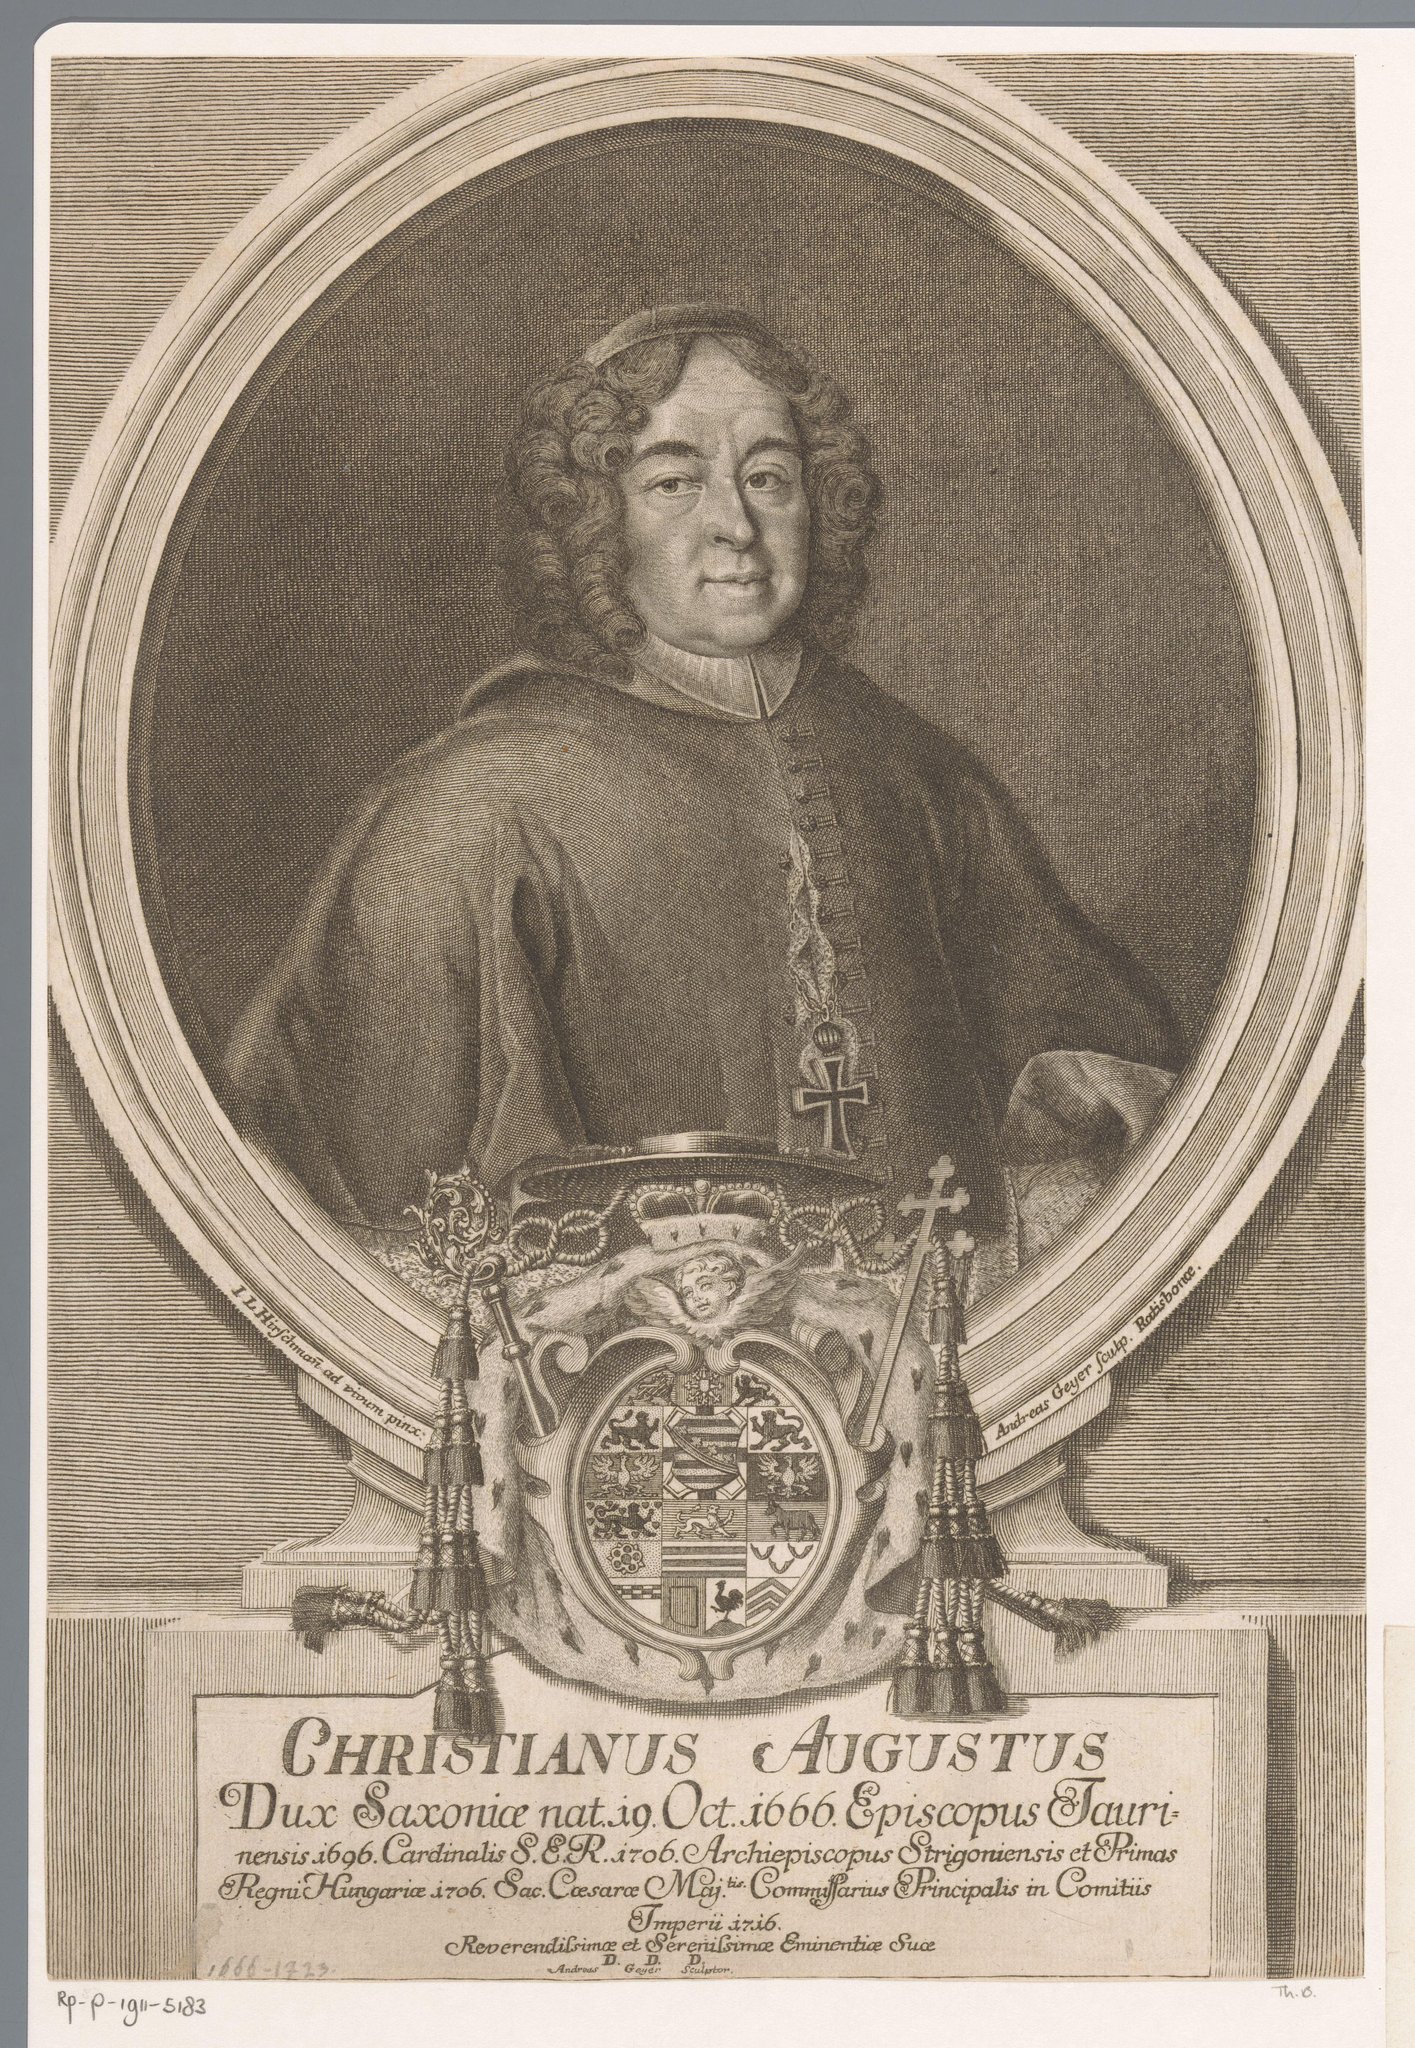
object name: print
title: Portret van Christian August zu Sachsen-Zeitz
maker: andreas geyer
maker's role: print maker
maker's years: -1729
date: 1716-1729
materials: paper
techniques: engraving, etching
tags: archbishop, bishop, etc. (roman catholic), insignia of bishop, e.g. mitre, crozier, historical persons, armorial bearing, heraldry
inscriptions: collector's mark: Lugt 2228